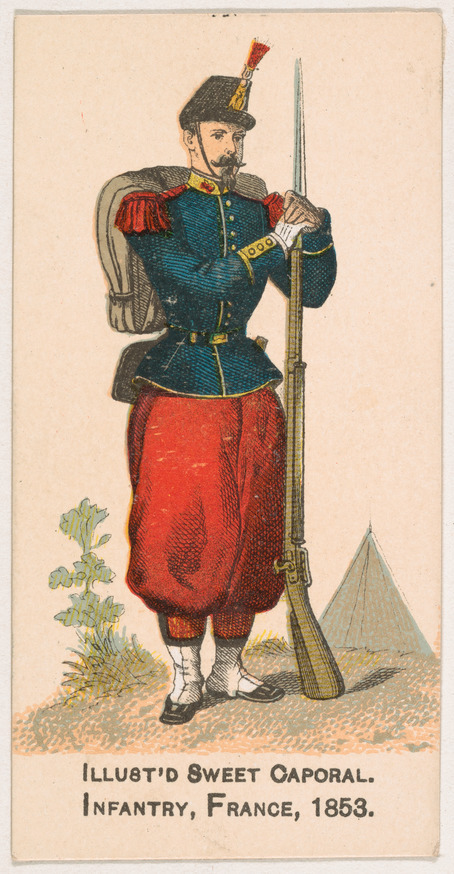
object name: print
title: Infantry, France, 1853, from the Military Series (N224) issued by Kinney Tobacco Company to promote Sweet Caporal Cigarettes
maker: kinney brothers tobacco company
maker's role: publisher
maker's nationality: american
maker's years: 1869-2011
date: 1888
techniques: color lithograph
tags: military,firearms,men